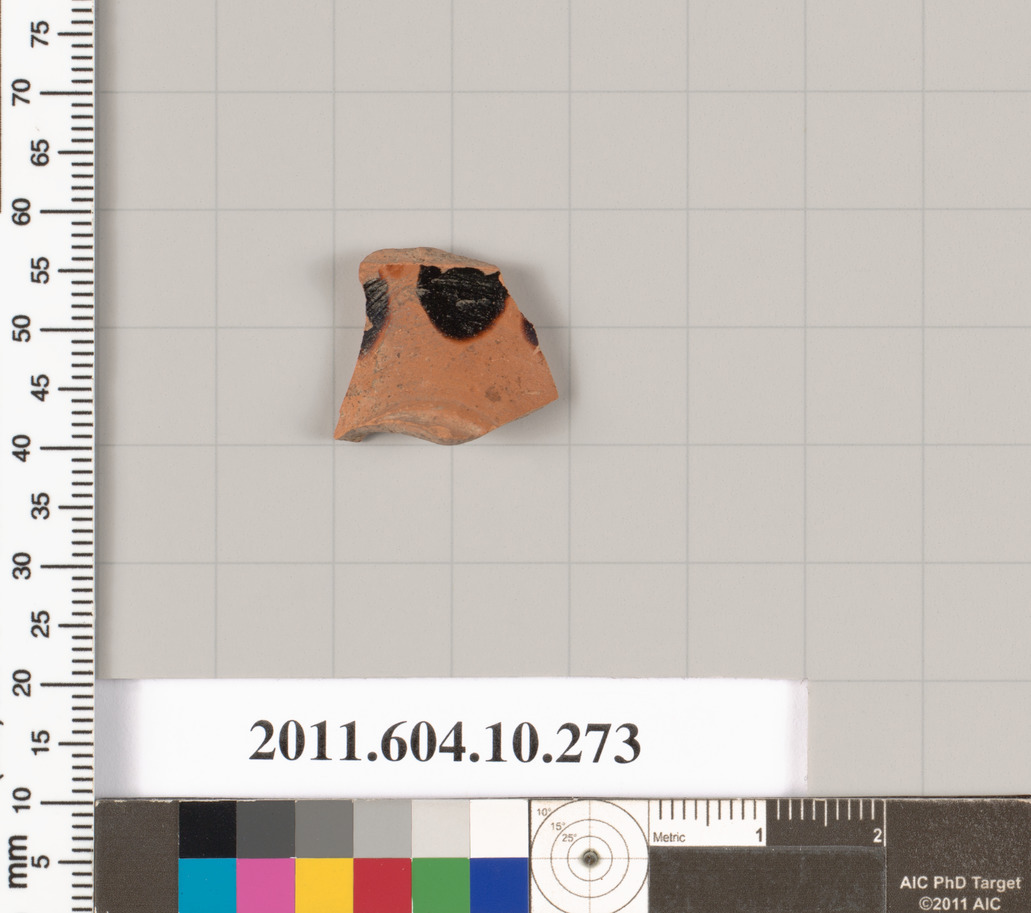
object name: unidentified closed shape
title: Terracotta fragment from a closed shape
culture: etruscan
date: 500-480 BCE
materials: terracotta